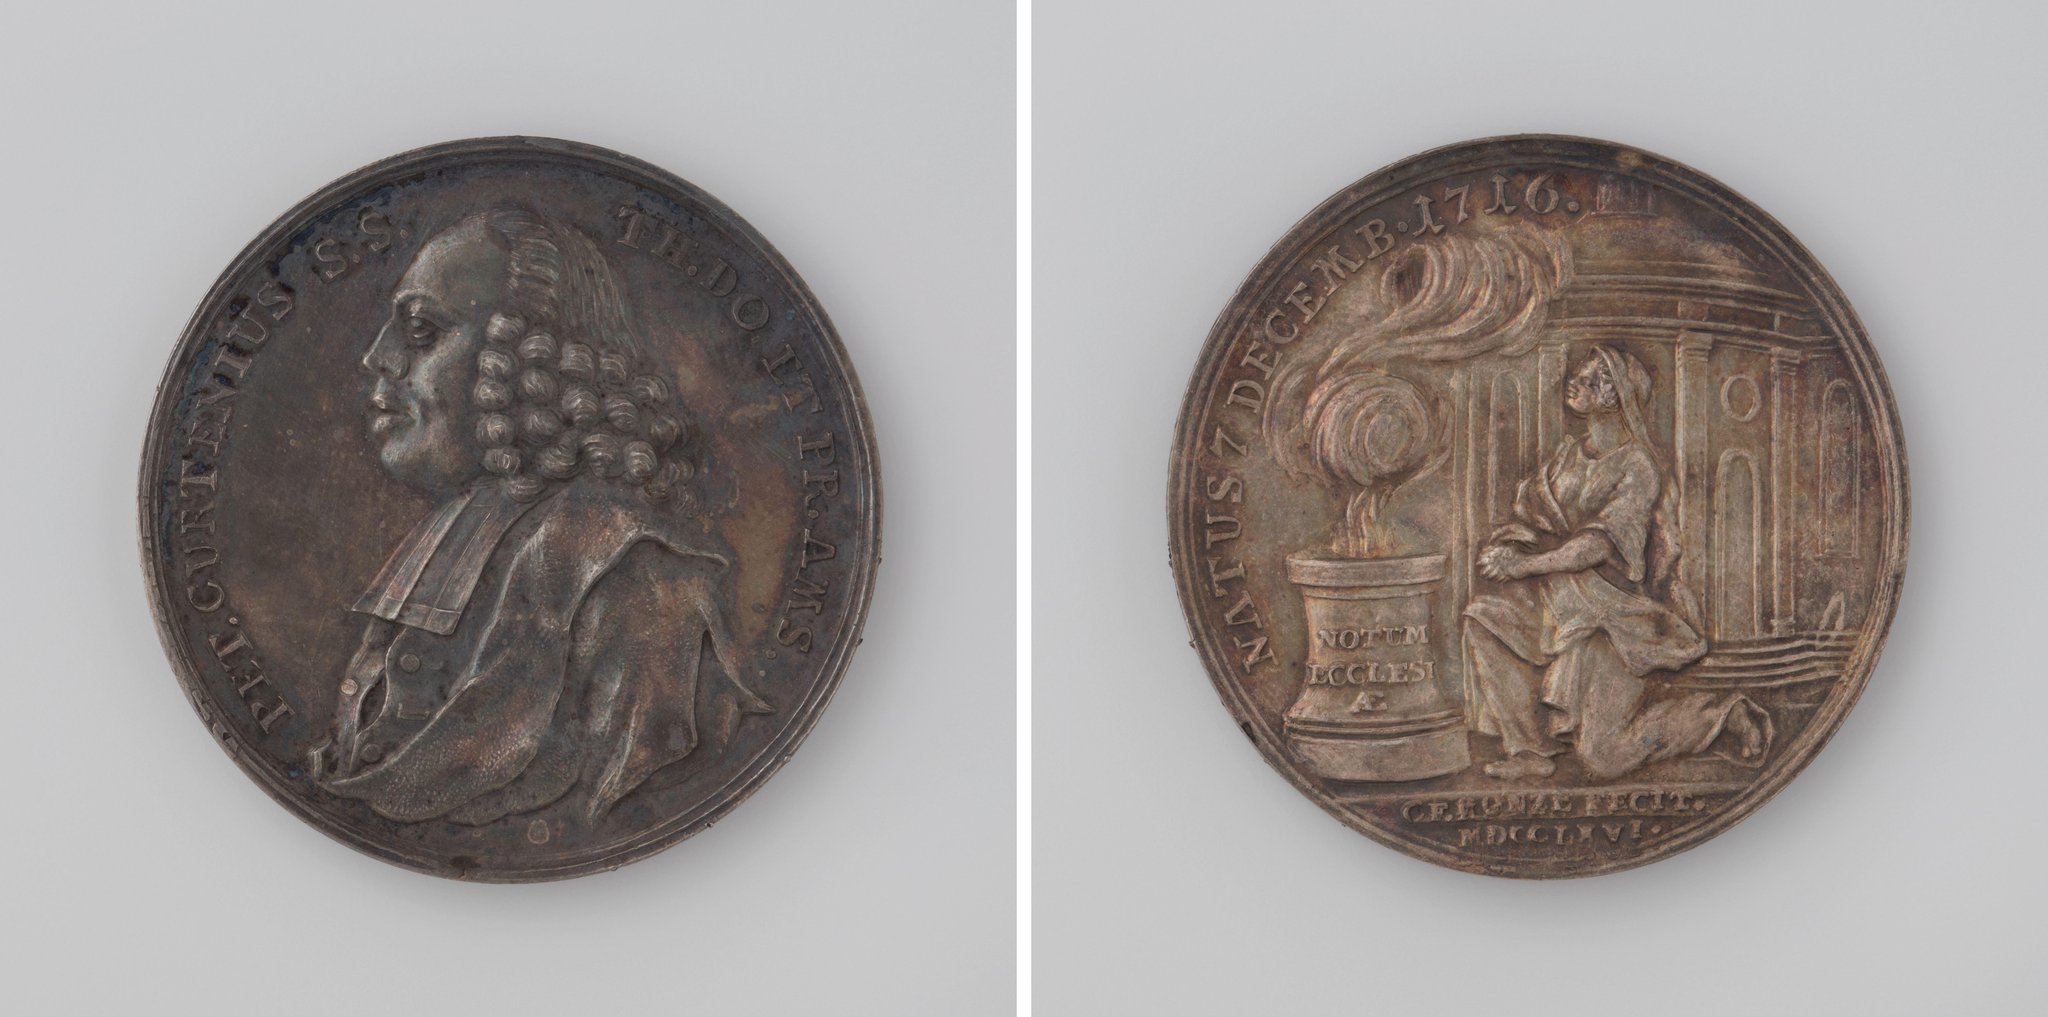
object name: family medal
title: Vijftigste verjaardag van Petrus Curtenius, professor in de theologie te Amsterdam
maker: carel frederik konsé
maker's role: painter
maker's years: 1736-1786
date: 1766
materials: silver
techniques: striking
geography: netherlands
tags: deventer, amsterdam, gouda